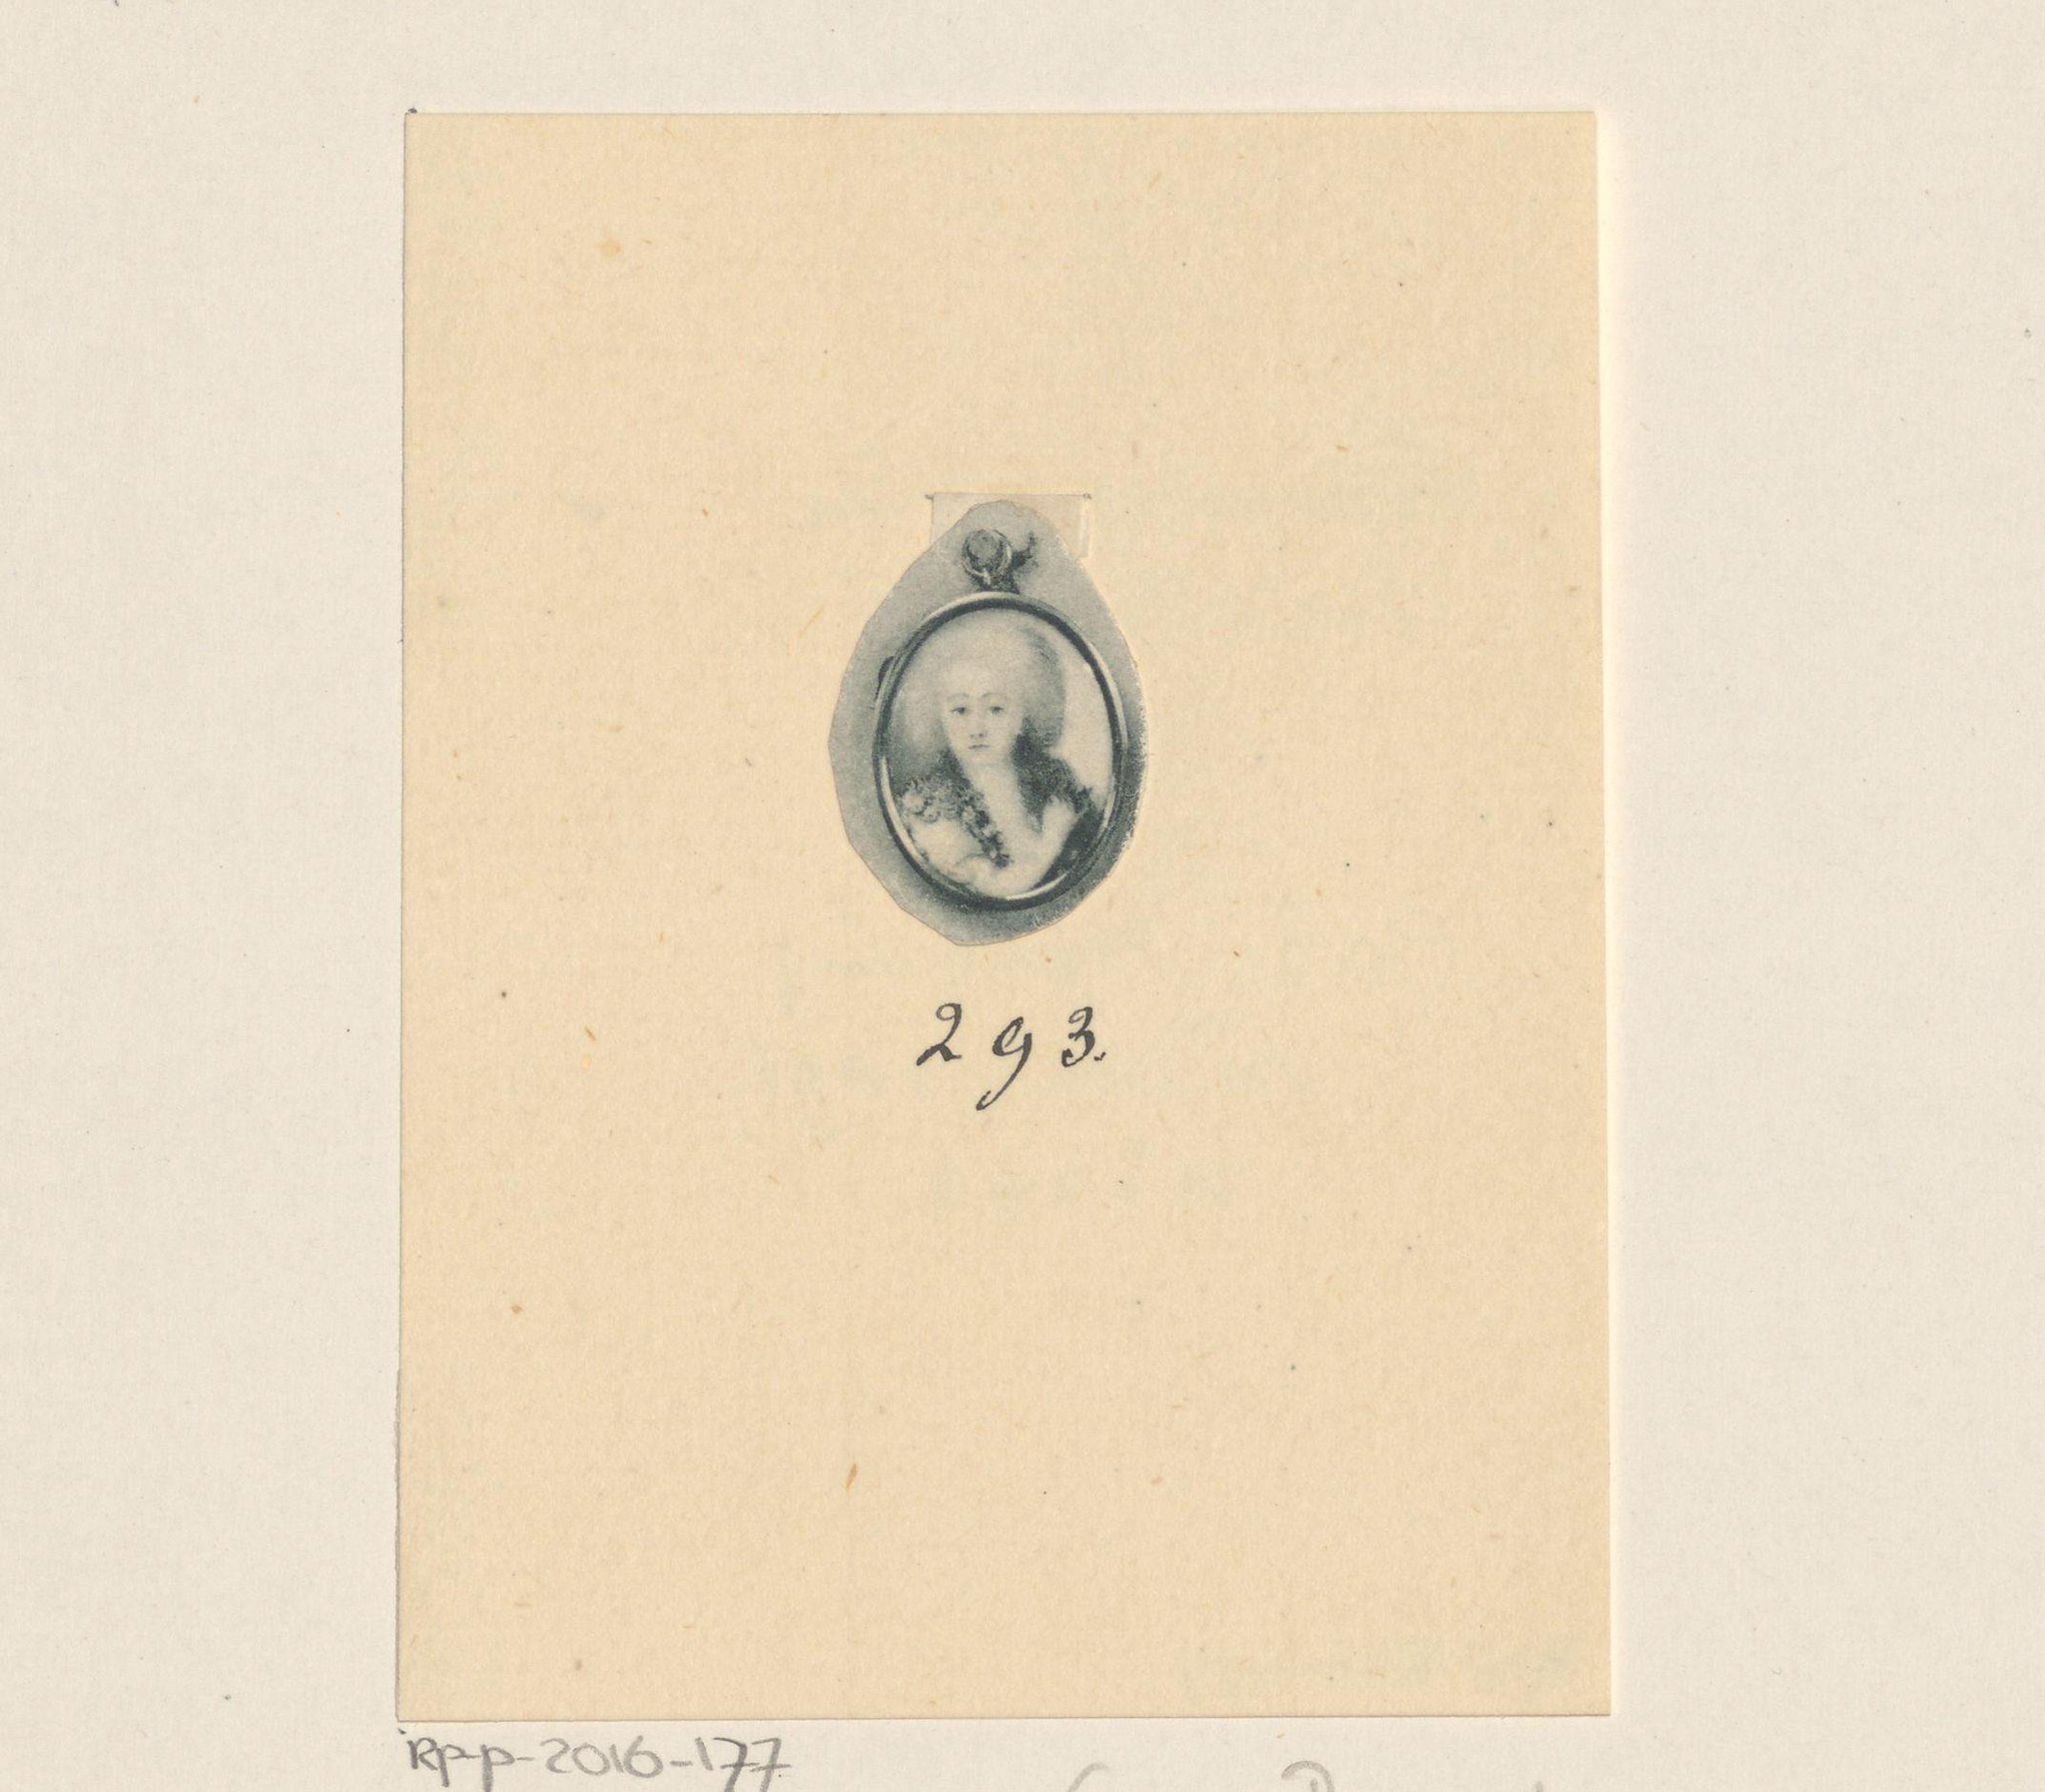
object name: photomechanical print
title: Portret van Felicitas Abt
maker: Anonymous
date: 1850-1949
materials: paper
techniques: photograph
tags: portrait of actor, actress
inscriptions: number: ‘293’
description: Portret van Felicitas Abt in een ovale omlijsting van een medaillon.